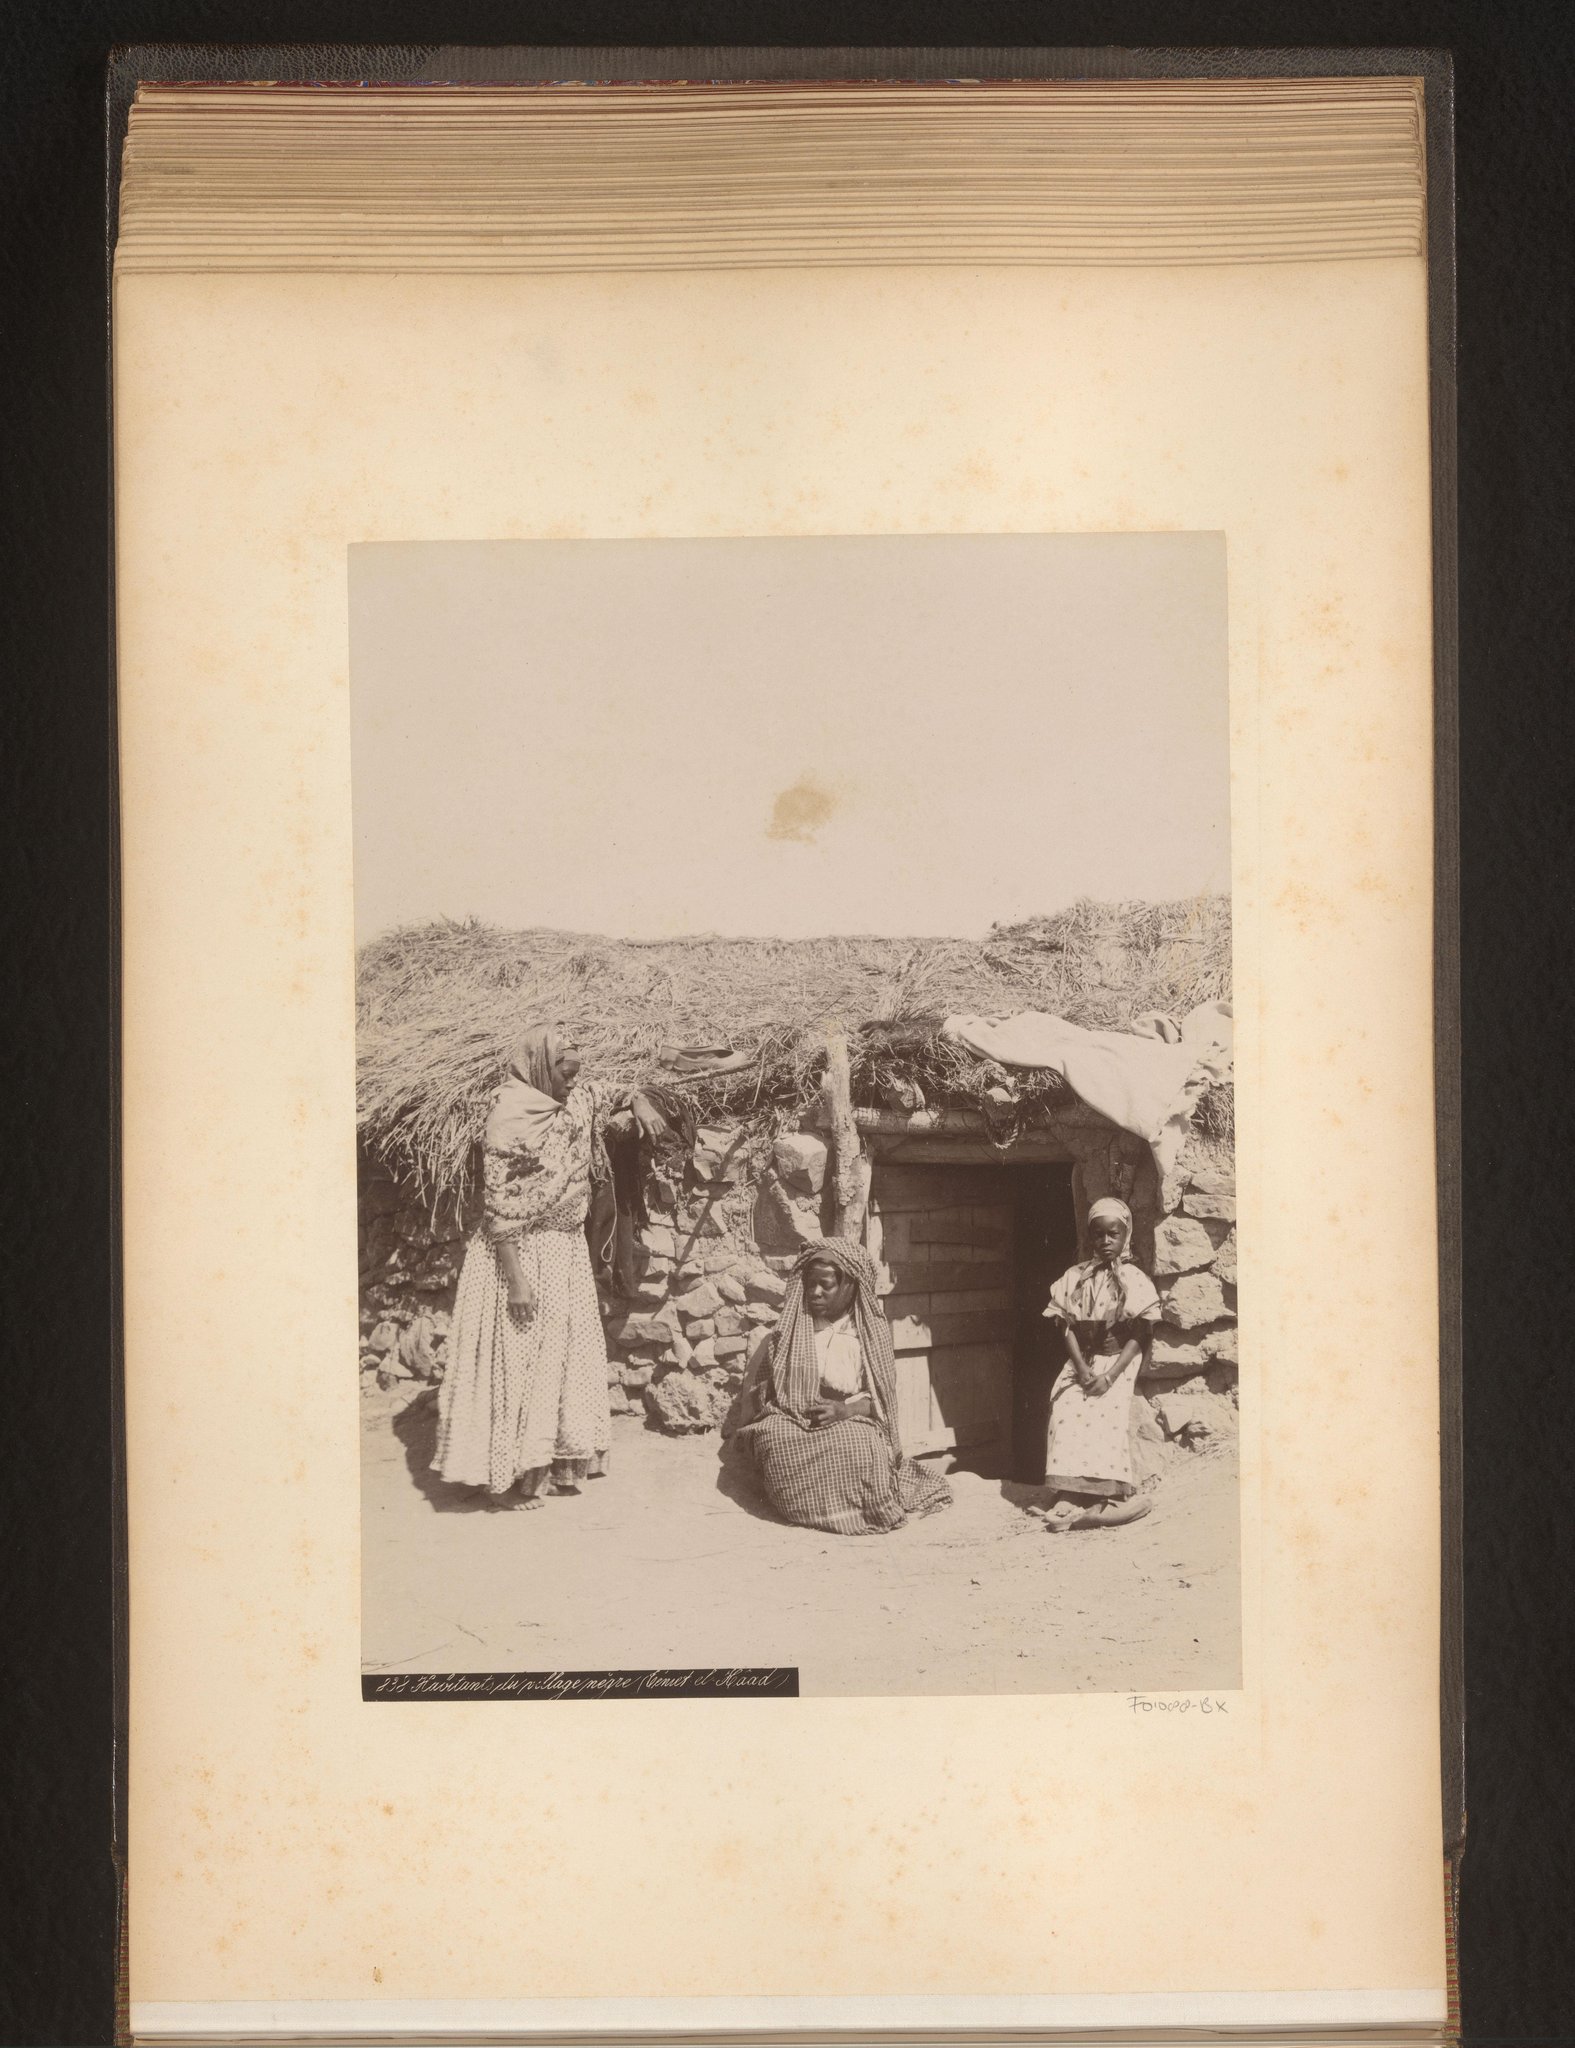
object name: photograph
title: Habitants du village negre (Ceniet-el-Kaad)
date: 1880-1900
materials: photographic support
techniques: albumen print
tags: adult woman, historical persons, housing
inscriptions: number: ‘238’